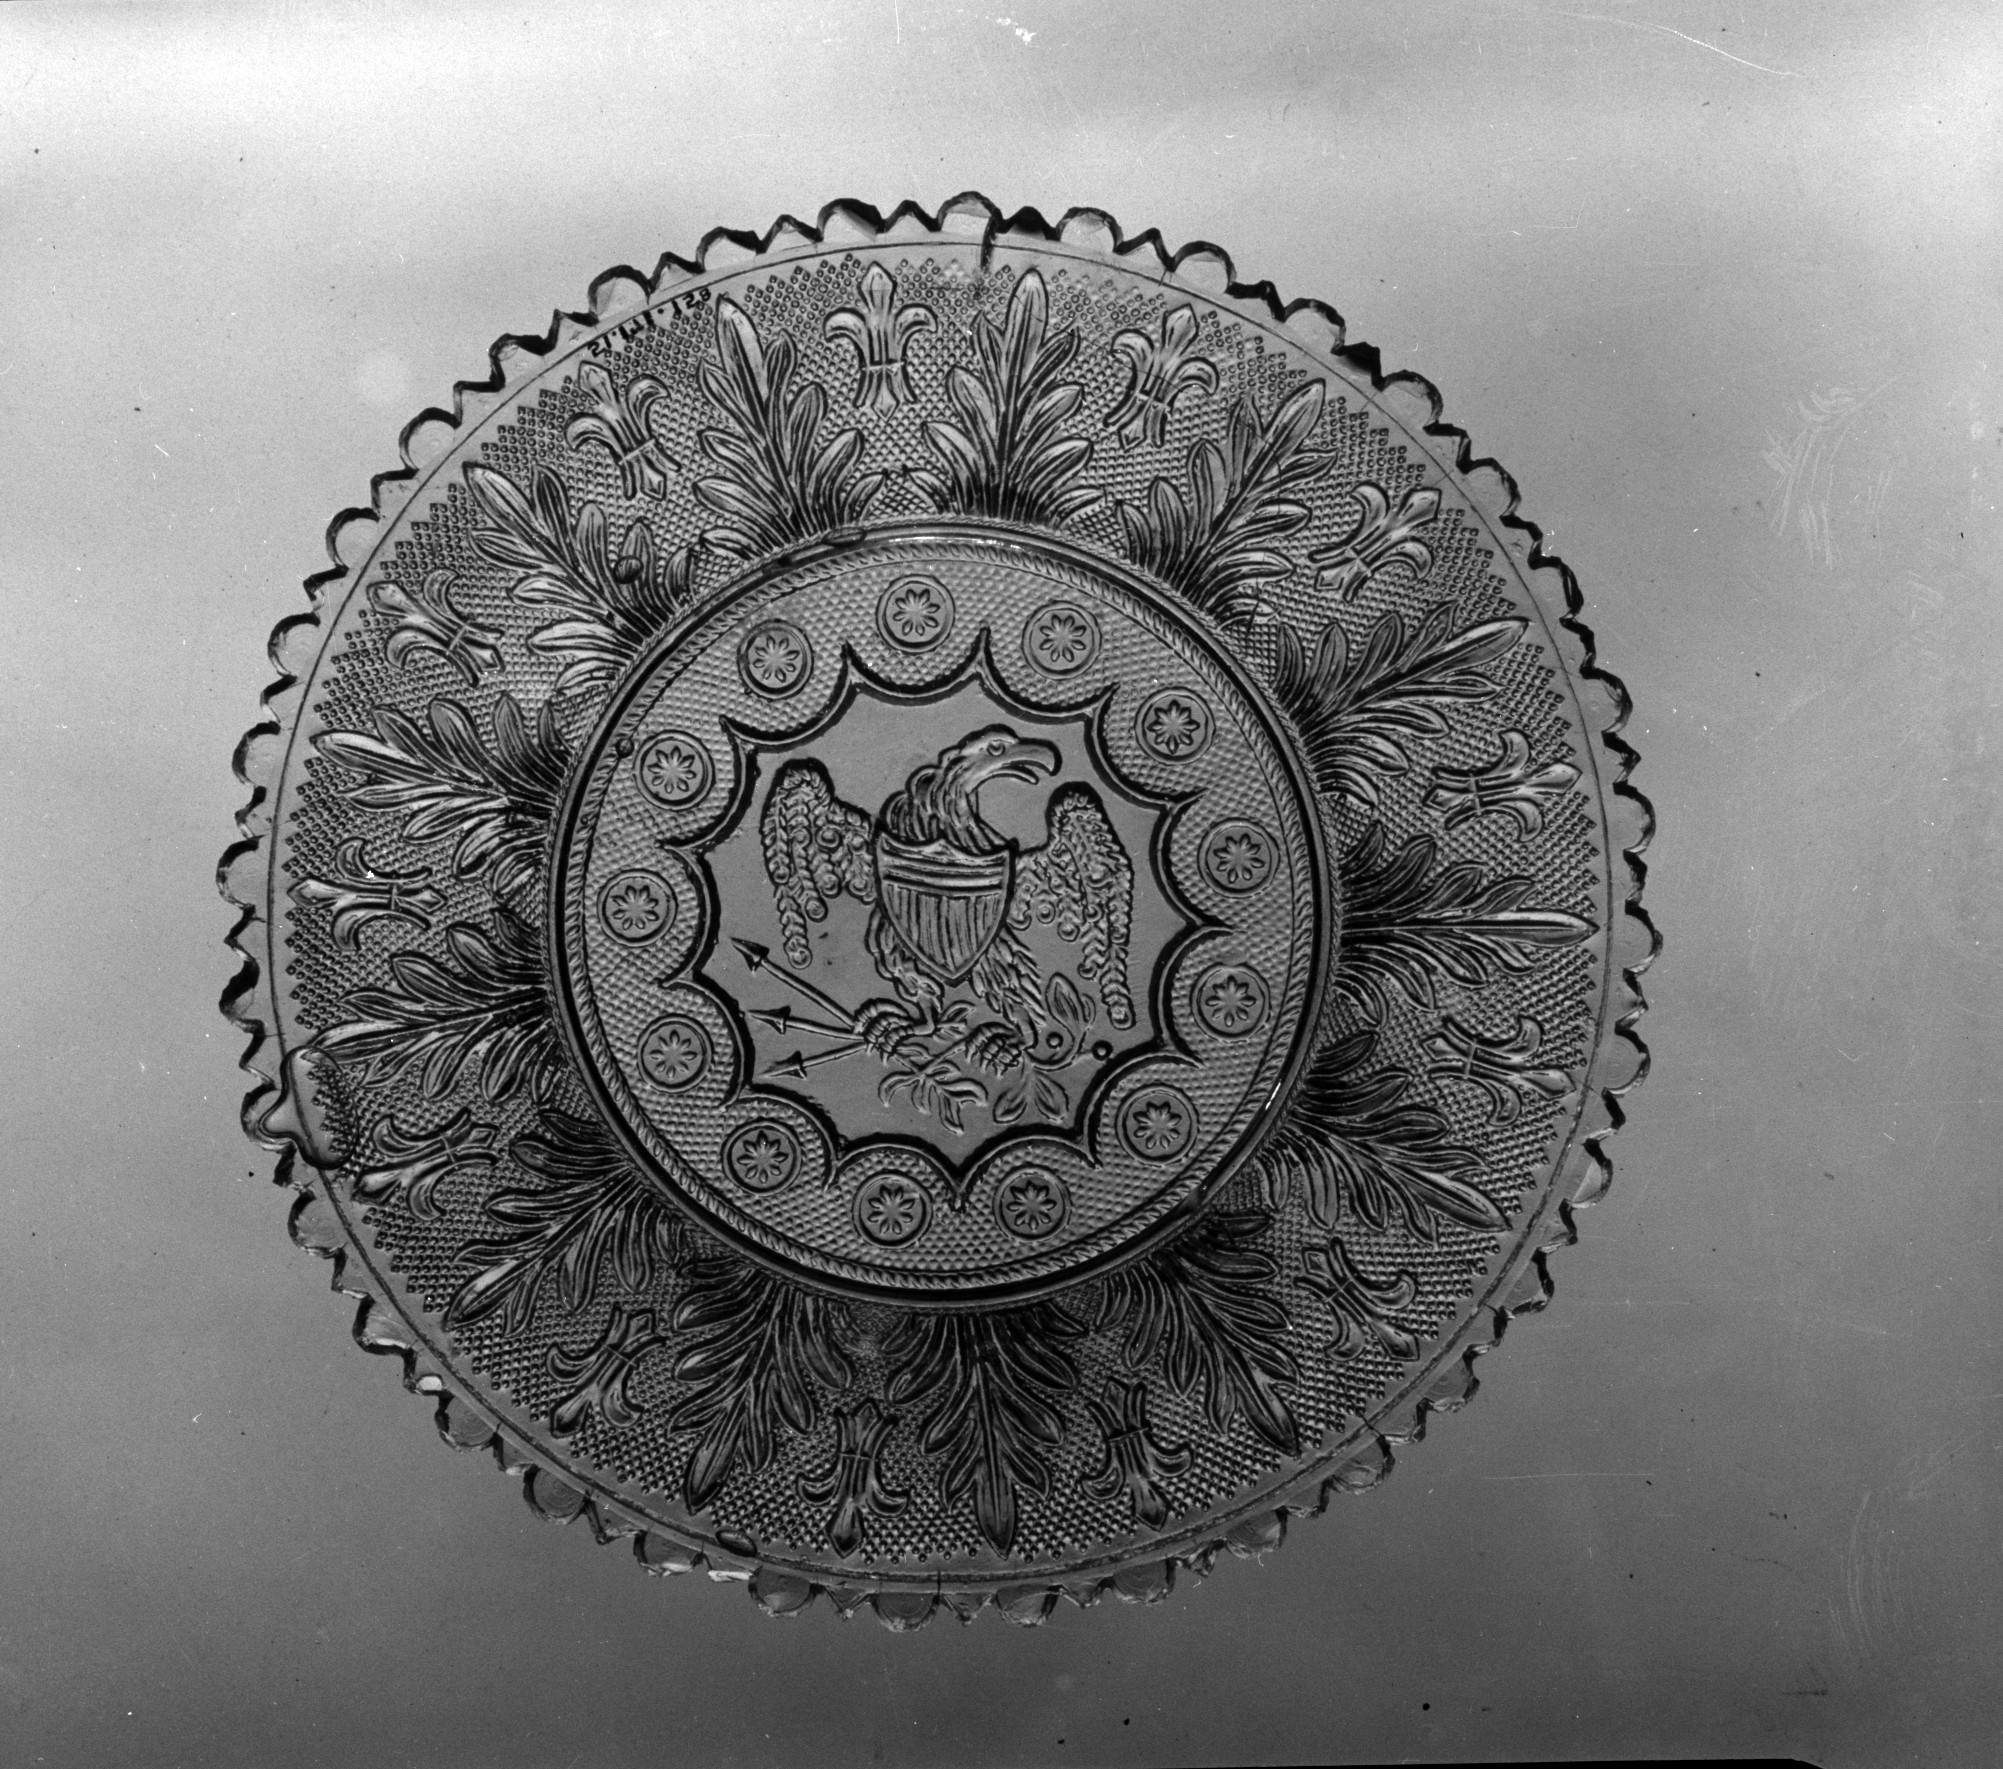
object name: plate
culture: american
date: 1830-1845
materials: glass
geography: united states